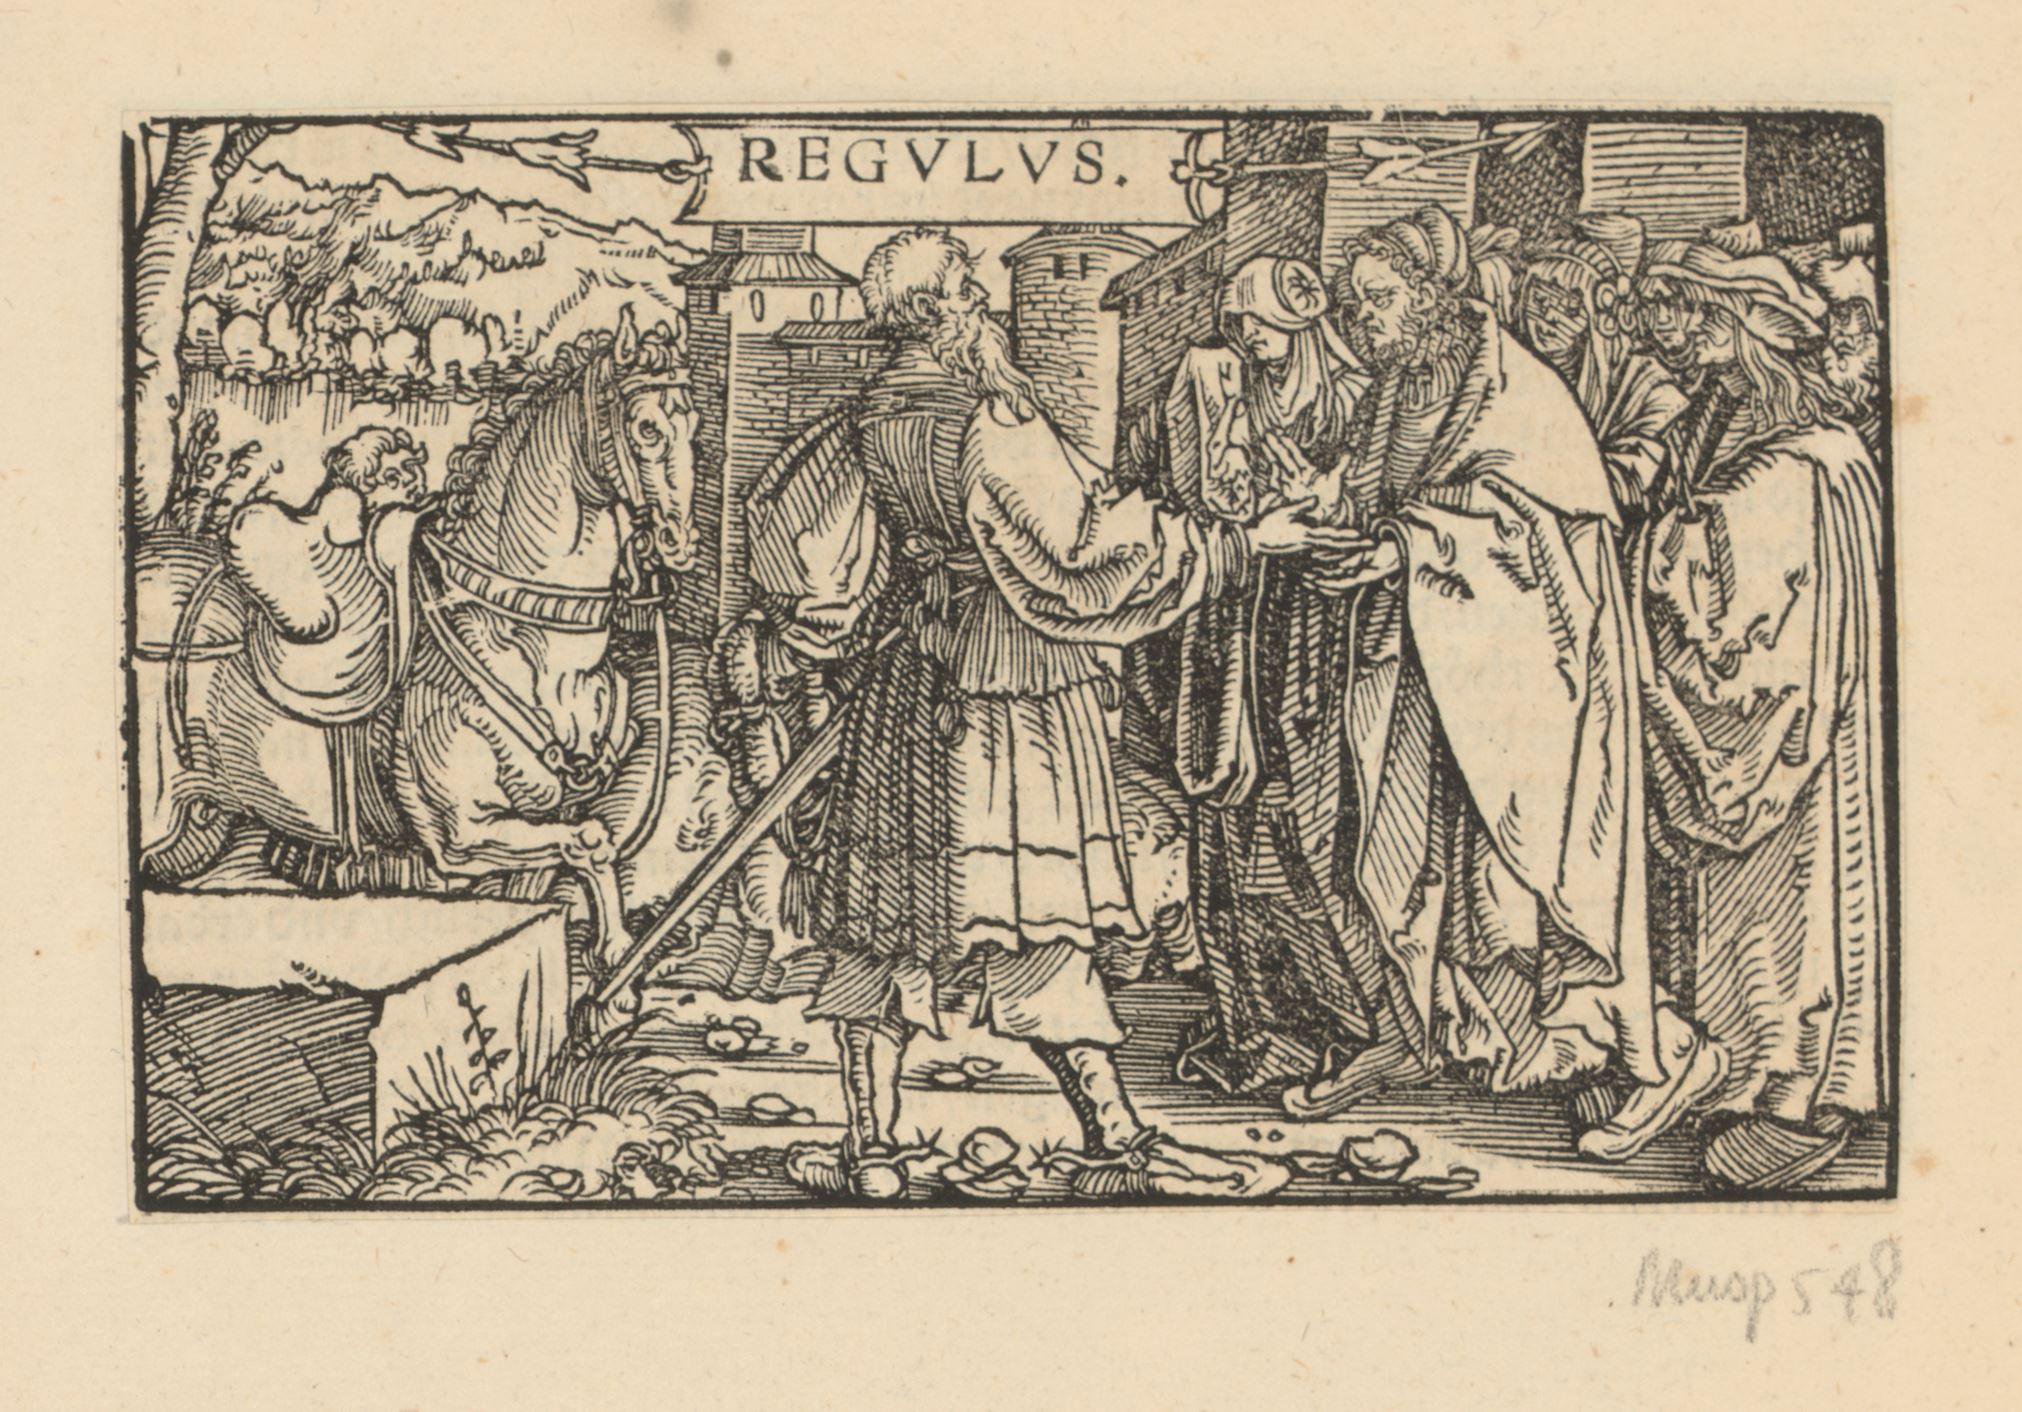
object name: print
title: Regulus neemt afscheid voordat hij naar het vijandige kamp vertrekt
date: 1514-1531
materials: paper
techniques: letterpress printing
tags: surprise attack (stratagem)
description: Deze prent is gebruikt in: Cicero, Marcus Tulius. Officia M.T.C. Ein Buch so Marcus Tullius Cicero der Römer zu seynem (...). [Vertaald uit het Latijn door] Johann von Schwarzenberg. Augsburg: Heinrich Steiner, 1531.